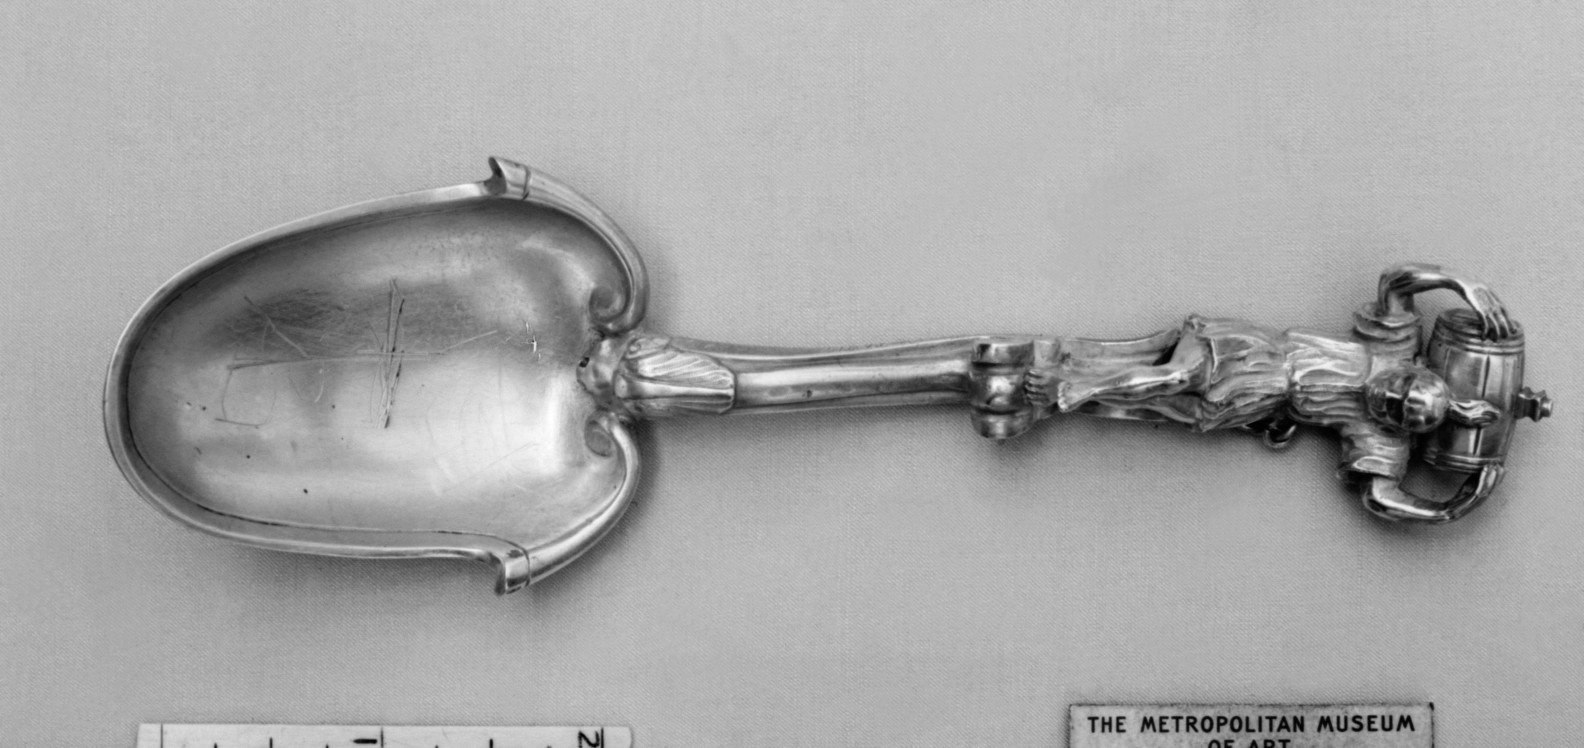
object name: spoon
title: Figure-top spoon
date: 1801-1900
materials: silver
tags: men